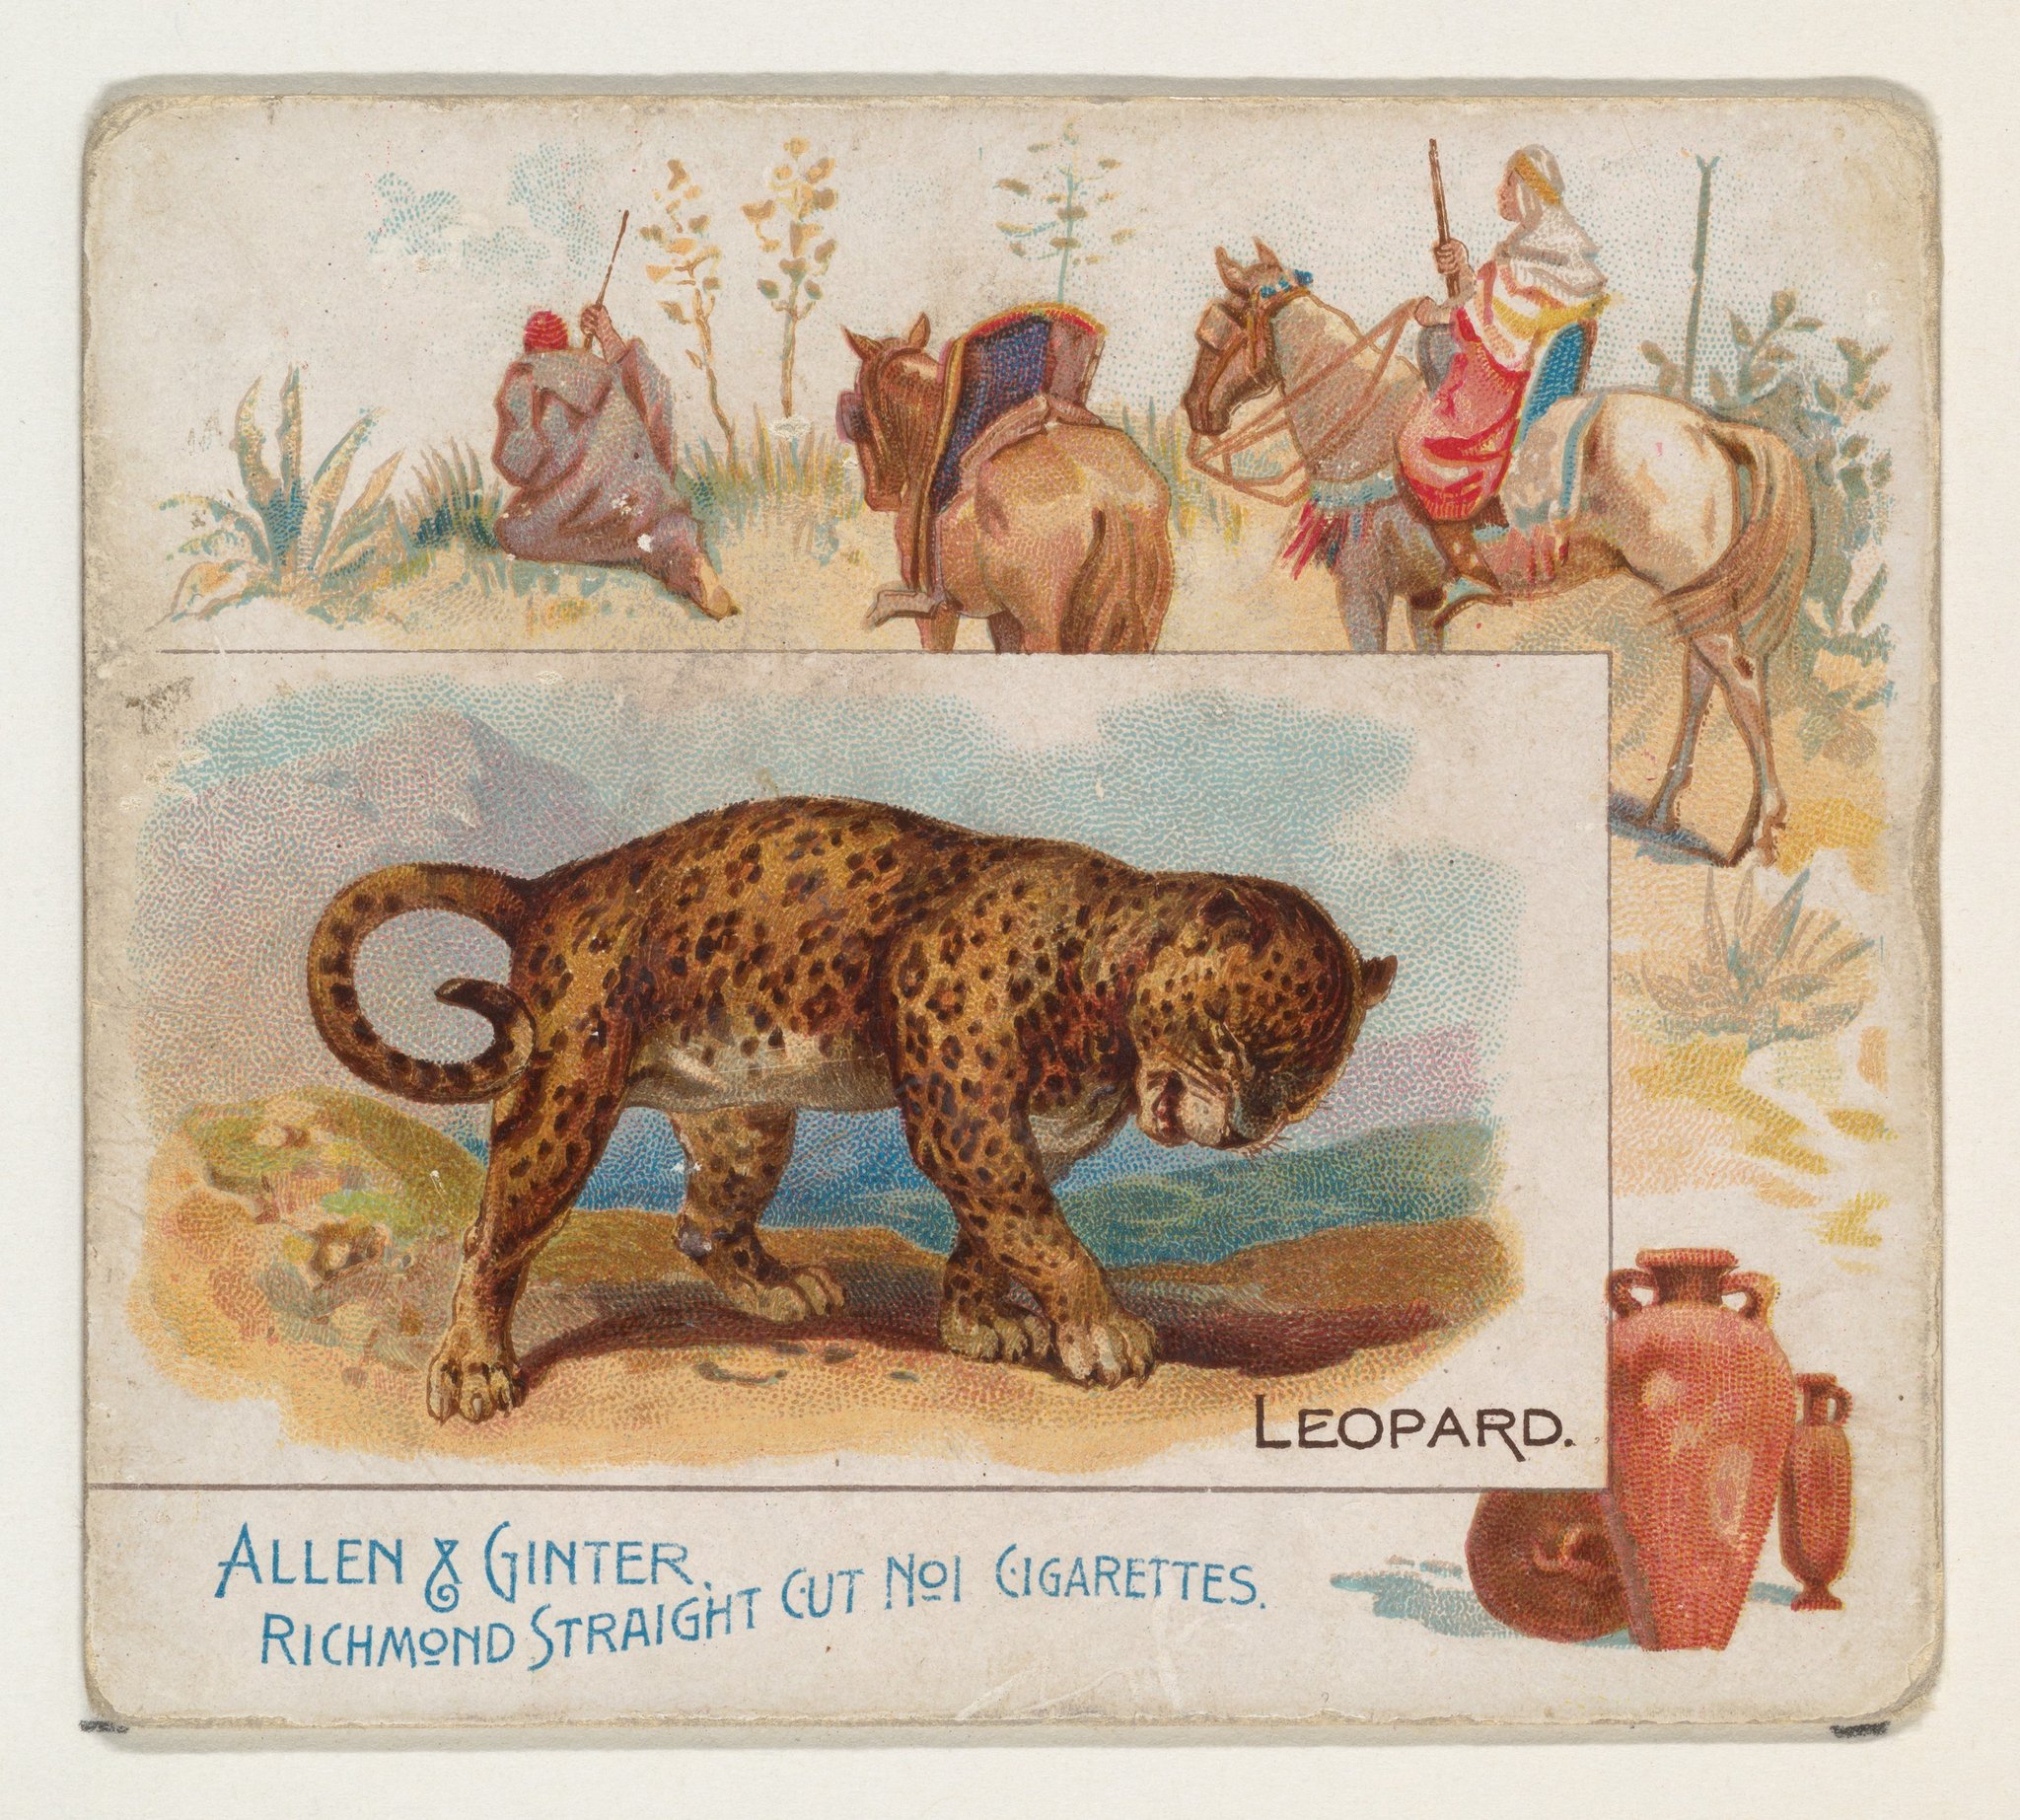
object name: print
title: Leopard, from Quadrupeds series (N41) for Allen & Ginter Cigarettes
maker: allen & ginter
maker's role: publisher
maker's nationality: american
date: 1890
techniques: color lithograph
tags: leopards